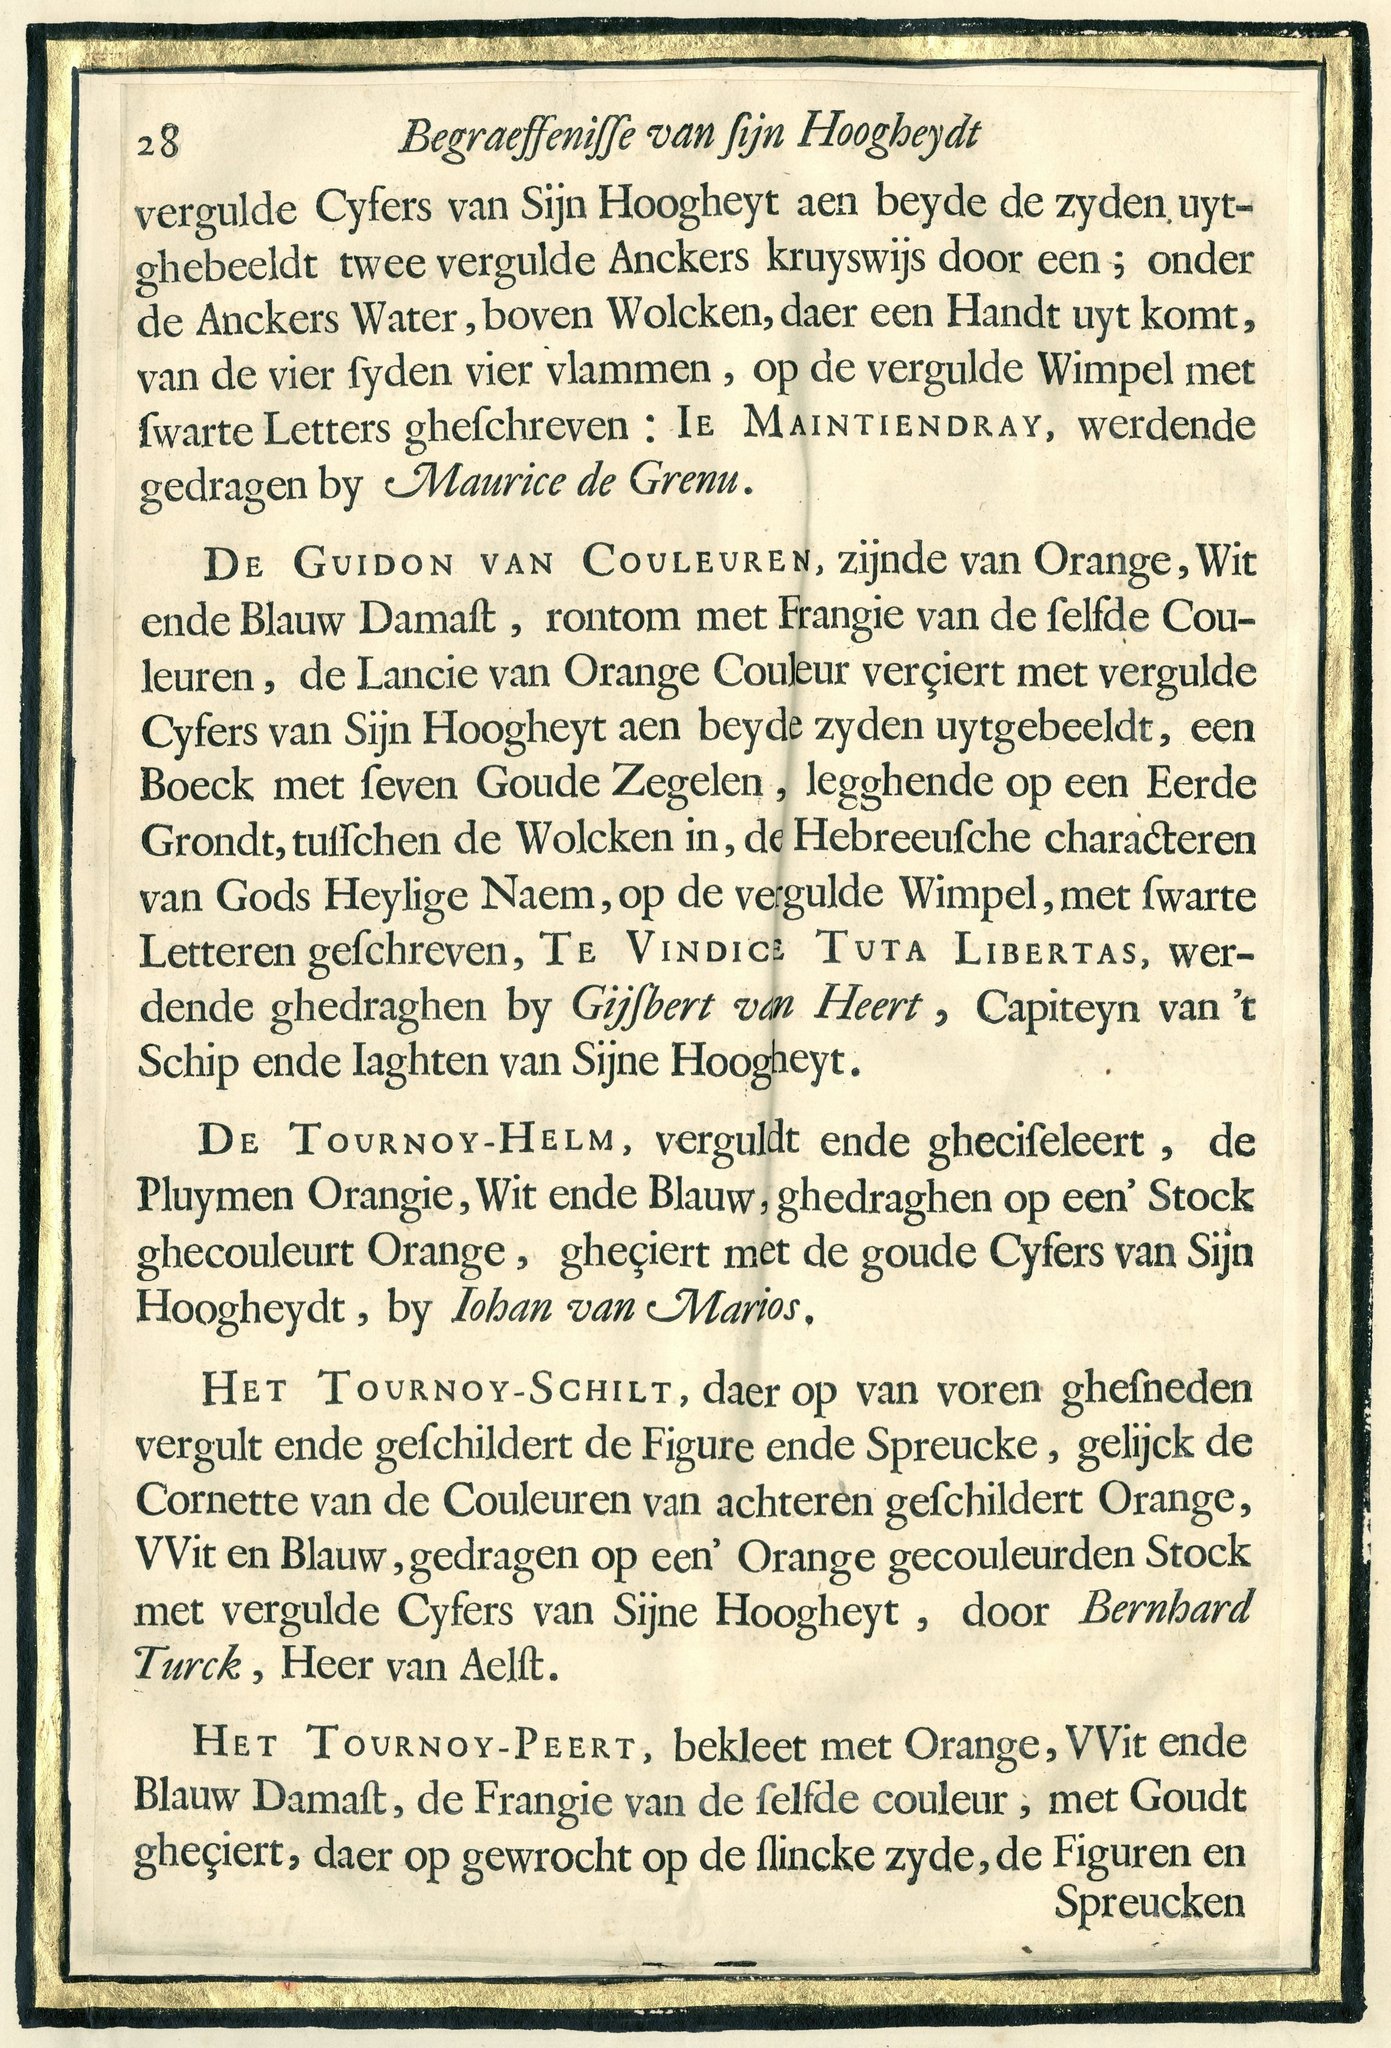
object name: text sheet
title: De beschrijving van de begrafenis van Frederik Hendrik, p. 28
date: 1651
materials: paint, paper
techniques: letterpress printing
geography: amsterdam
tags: frederick henry (prince of orange)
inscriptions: date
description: Pagina 28 van de beschrijving van de begrafenis van Frederik Hendrik. Blad uitgeknipt, versierd met goud en ingeplakt in de luxe editie uit ca. 1755 van het boek 'Begraeffenisse van syne hoogheyt Frederick Henrick' van Pieter Post, uitgegeven te Amsterdam in 1651.